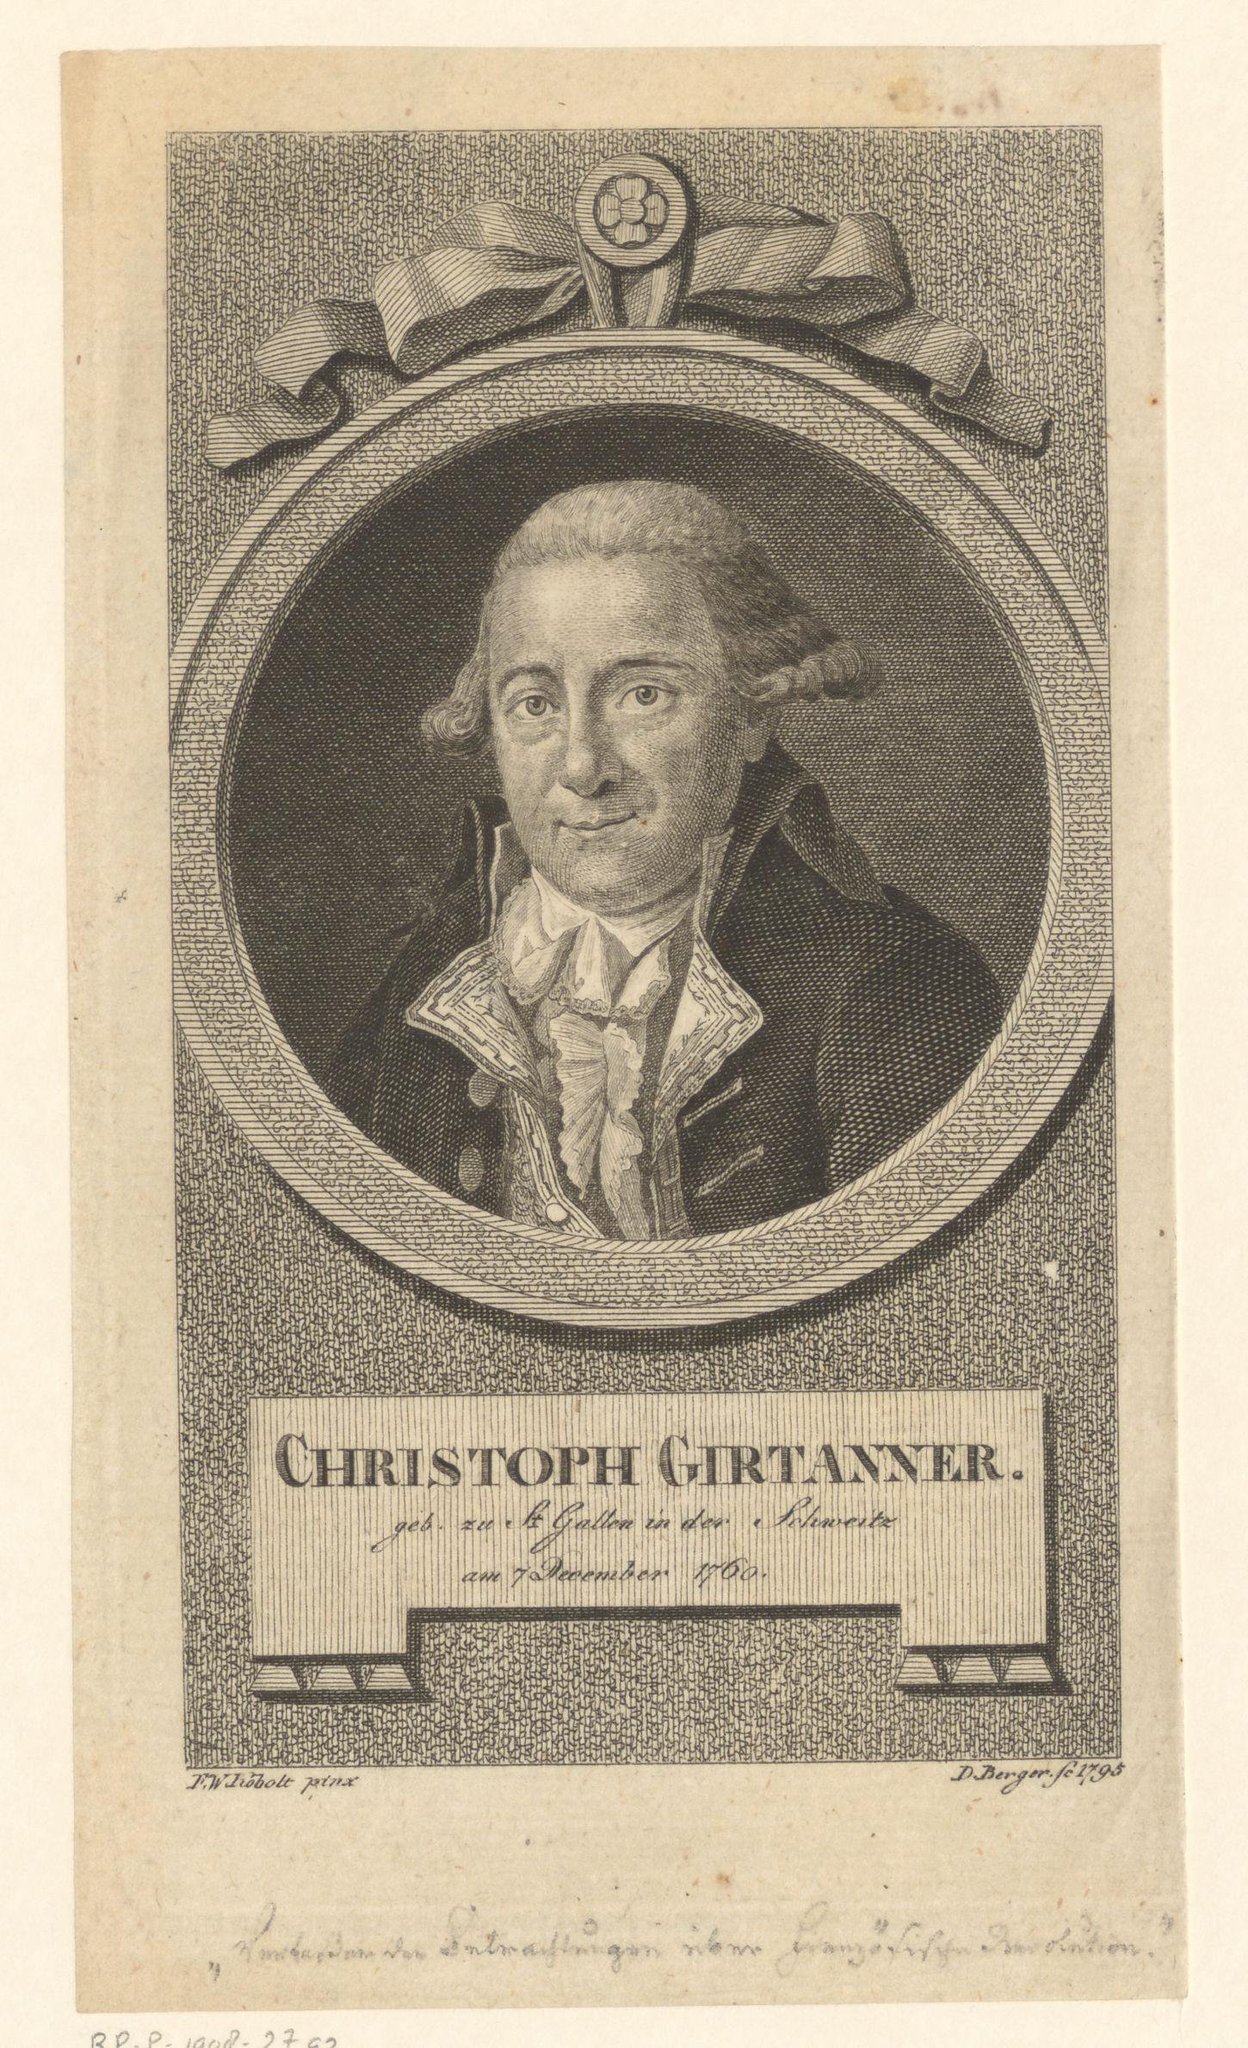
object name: print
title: Portret van Christoph Girtanner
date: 1795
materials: paper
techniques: engraving, etching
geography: berlin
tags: historical persons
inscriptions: collector's mark: Lugt 2228